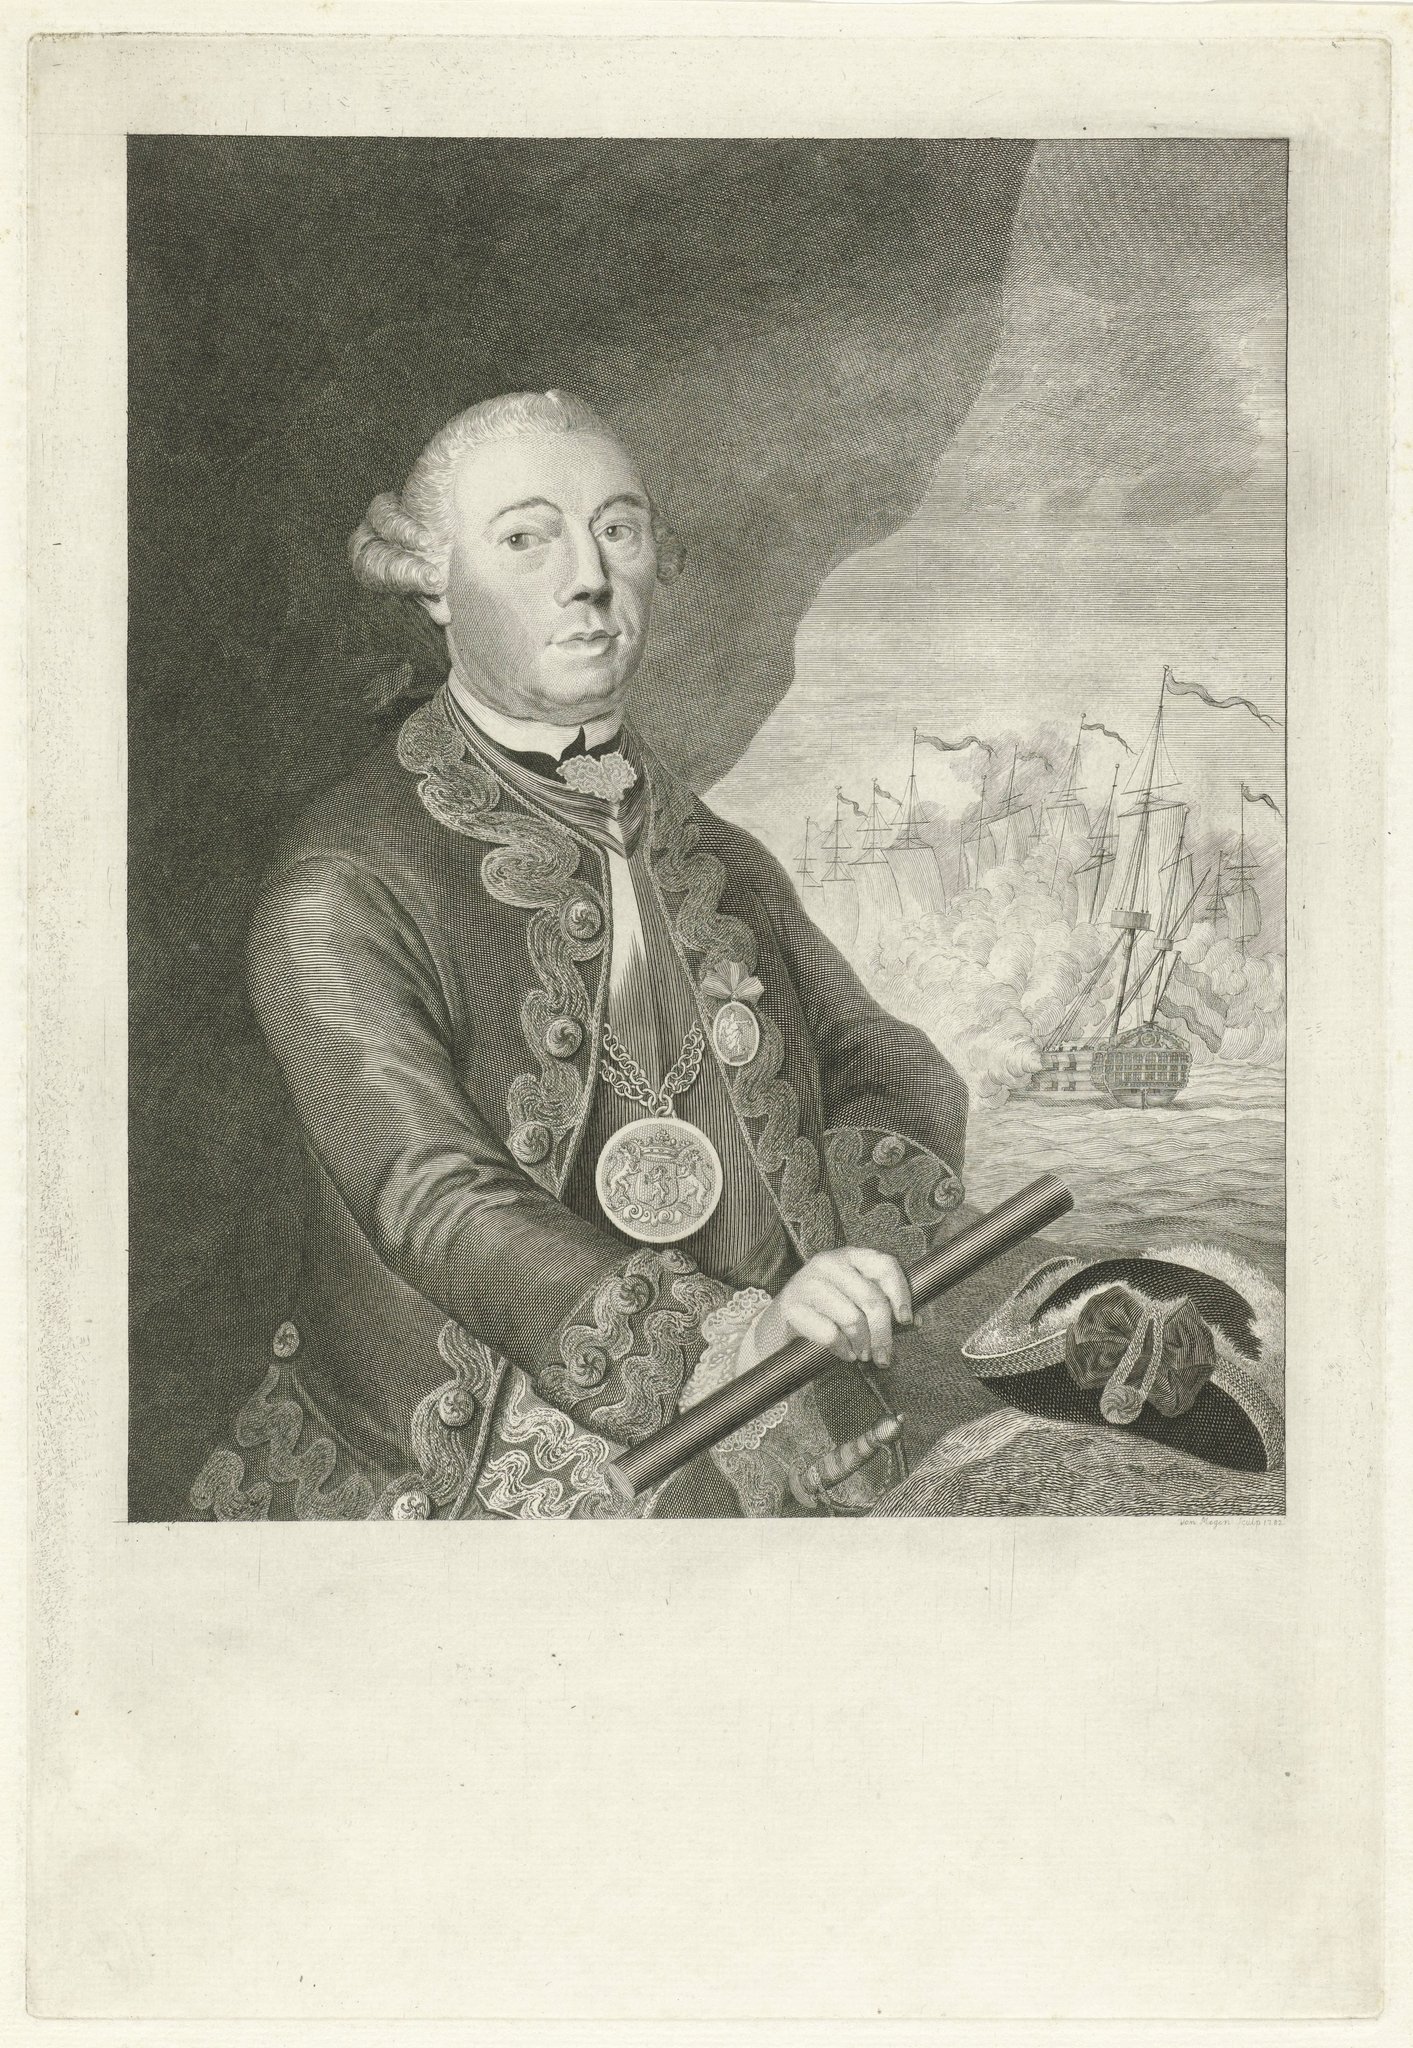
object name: print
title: Portret van Johan Arnold Zoutman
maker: pieter willem van megen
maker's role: print maker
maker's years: 1750-1785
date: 1782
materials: paper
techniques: engraving, etching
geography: the hague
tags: the hague, johan arnold zoutman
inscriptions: collector's mark: Lugt 240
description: Portret van Johan Arnold Zoutman, vice-admiraal van Holland en West-Friesland, met een bevelhebberstaf in zijn hand. Op de achtergrond de Slag bij de Doggersbank.